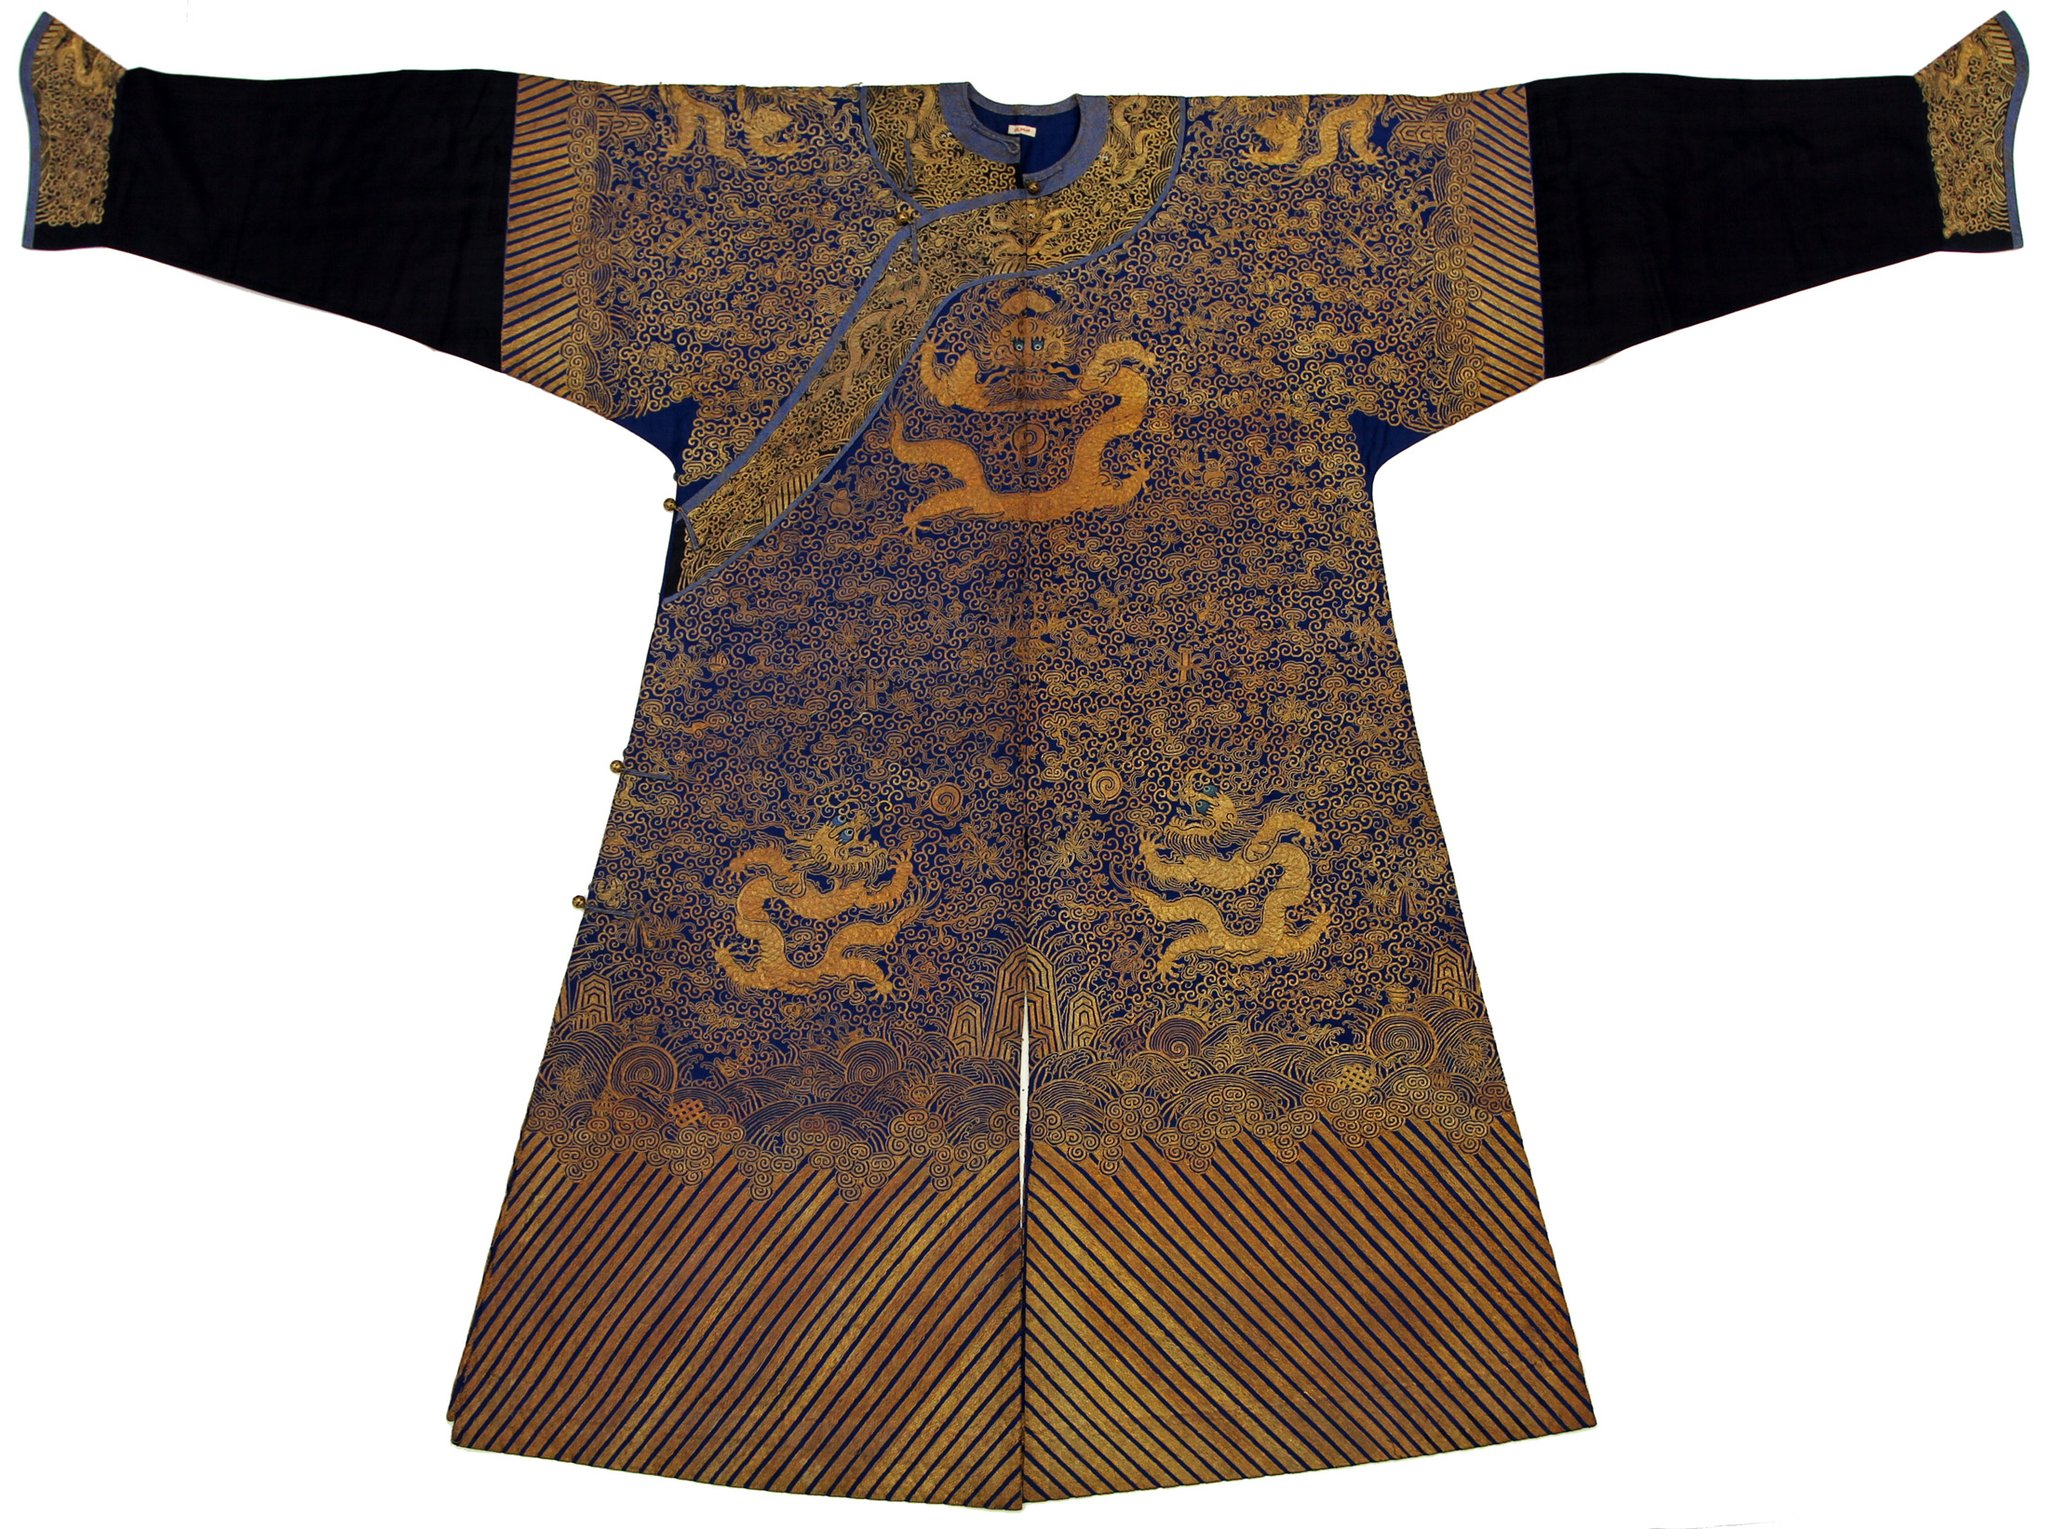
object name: robe, imperial court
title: Imperial Court Robe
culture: chinese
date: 1801-1900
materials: metal thread, silk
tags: dragons